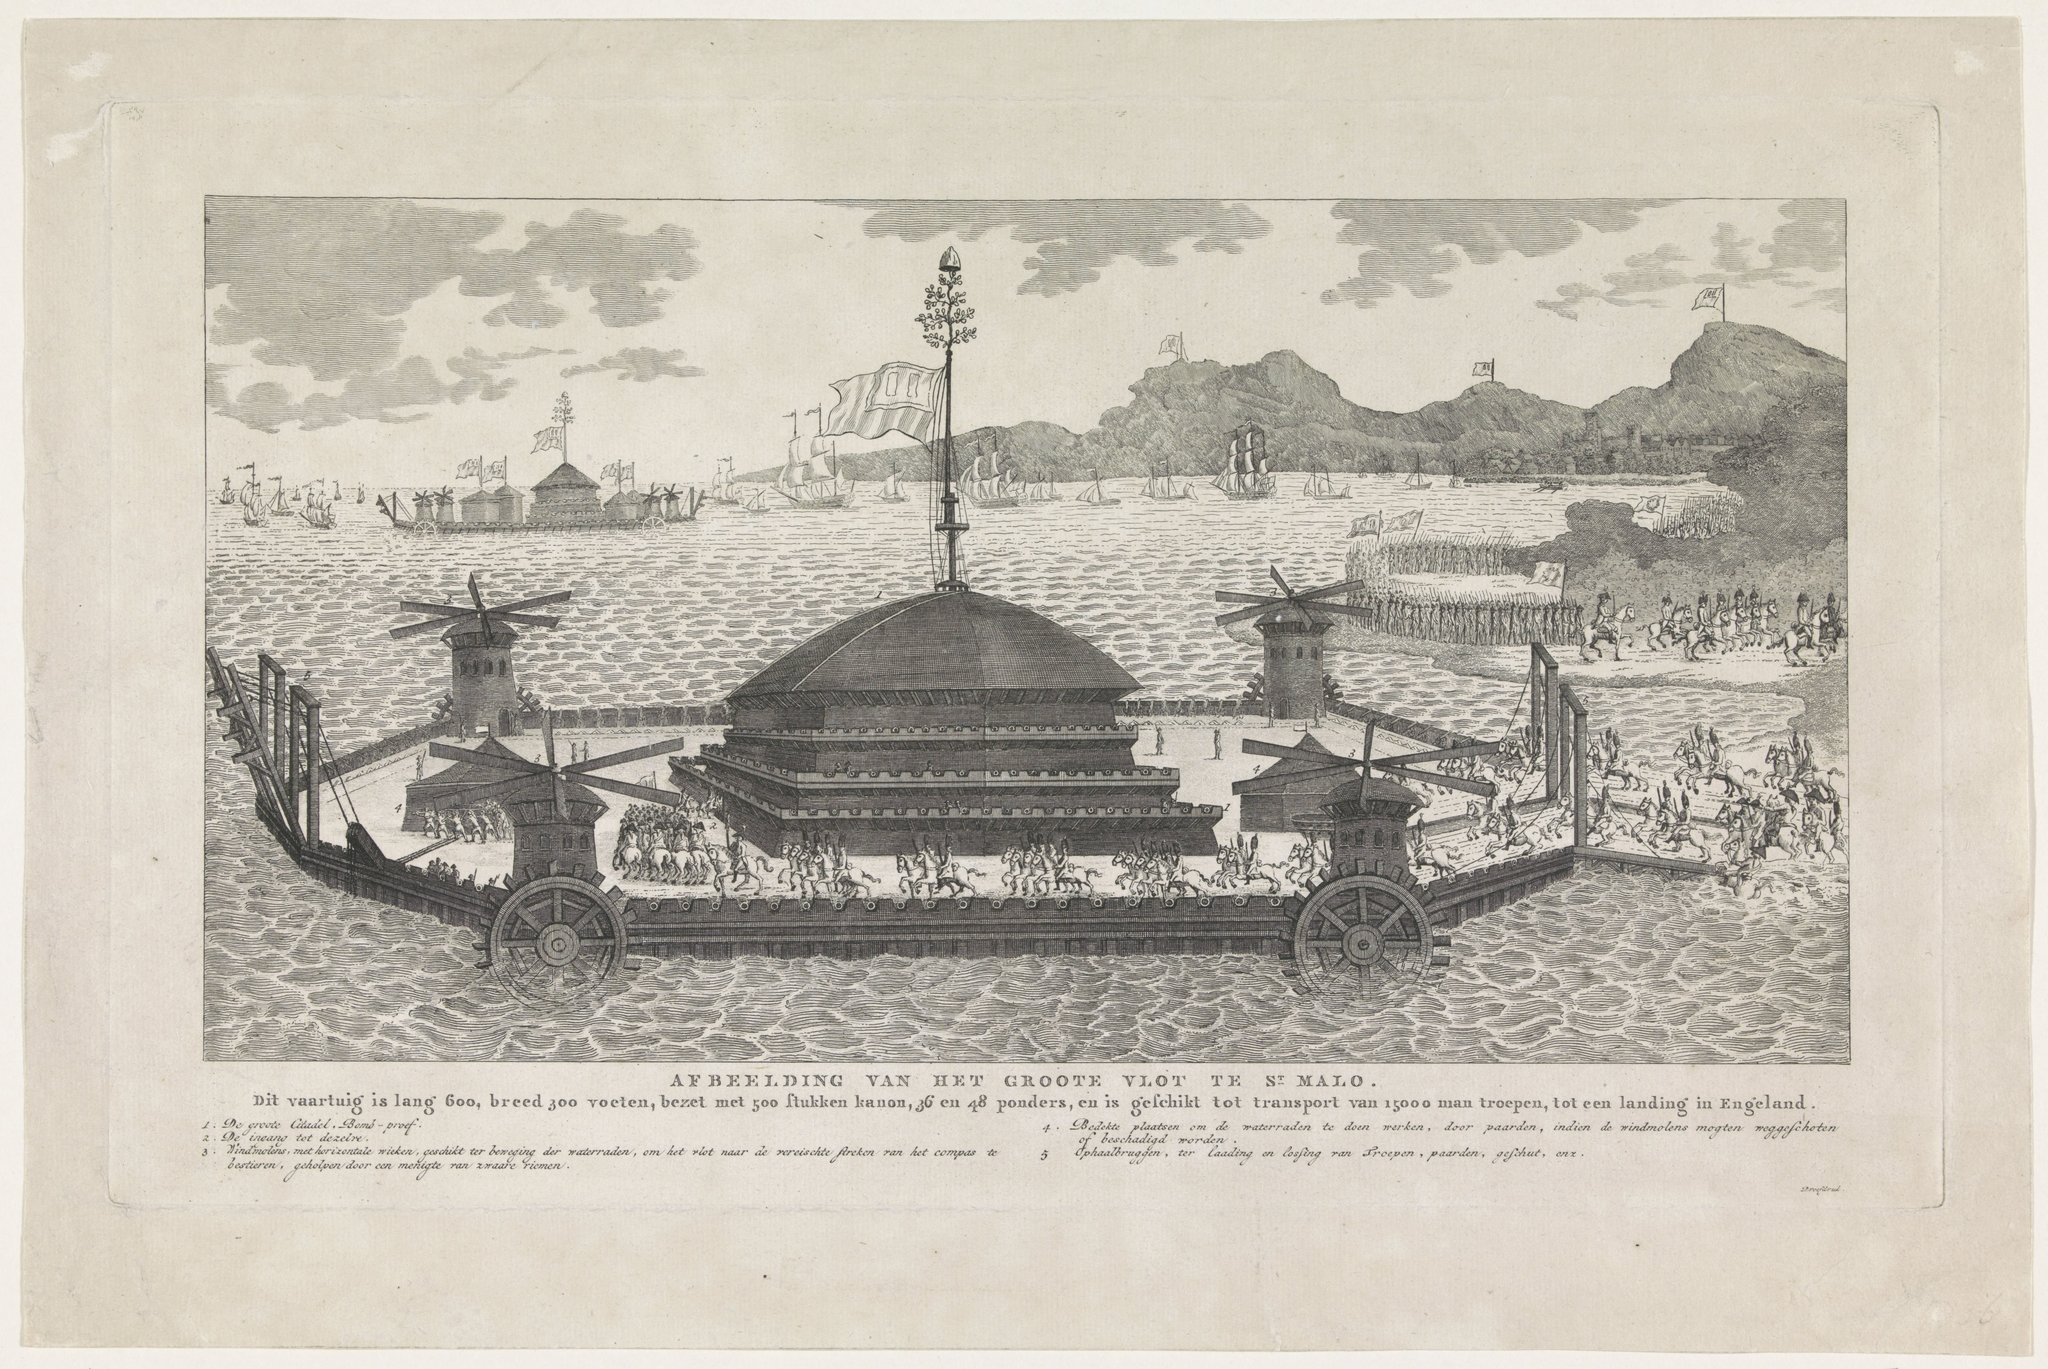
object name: print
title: Vlot van Saint-Malo, 1797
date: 1798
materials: paper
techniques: engraving, etching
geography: netherlands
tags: navy (+ naval force), raft (+ propulsion of vehicle, ship, etc. by wind)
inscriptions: collector's mark: Lugt 2228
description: Frans vlot of drijvend kasteel waarmee 15.000 met paarden en geschut getransporteerd moesten kunnen worden. Ontworpen door de Franse ingenieur Le Blanc voor de invasie van Engeland vanuit Frankrijk, februari 1797. Centraal op het vlot een vesting of kasteel, op de vier hoeken raderen in het water aangedreven door windmolens of paardenkracht. In het onderschrift de legenda 1-5.